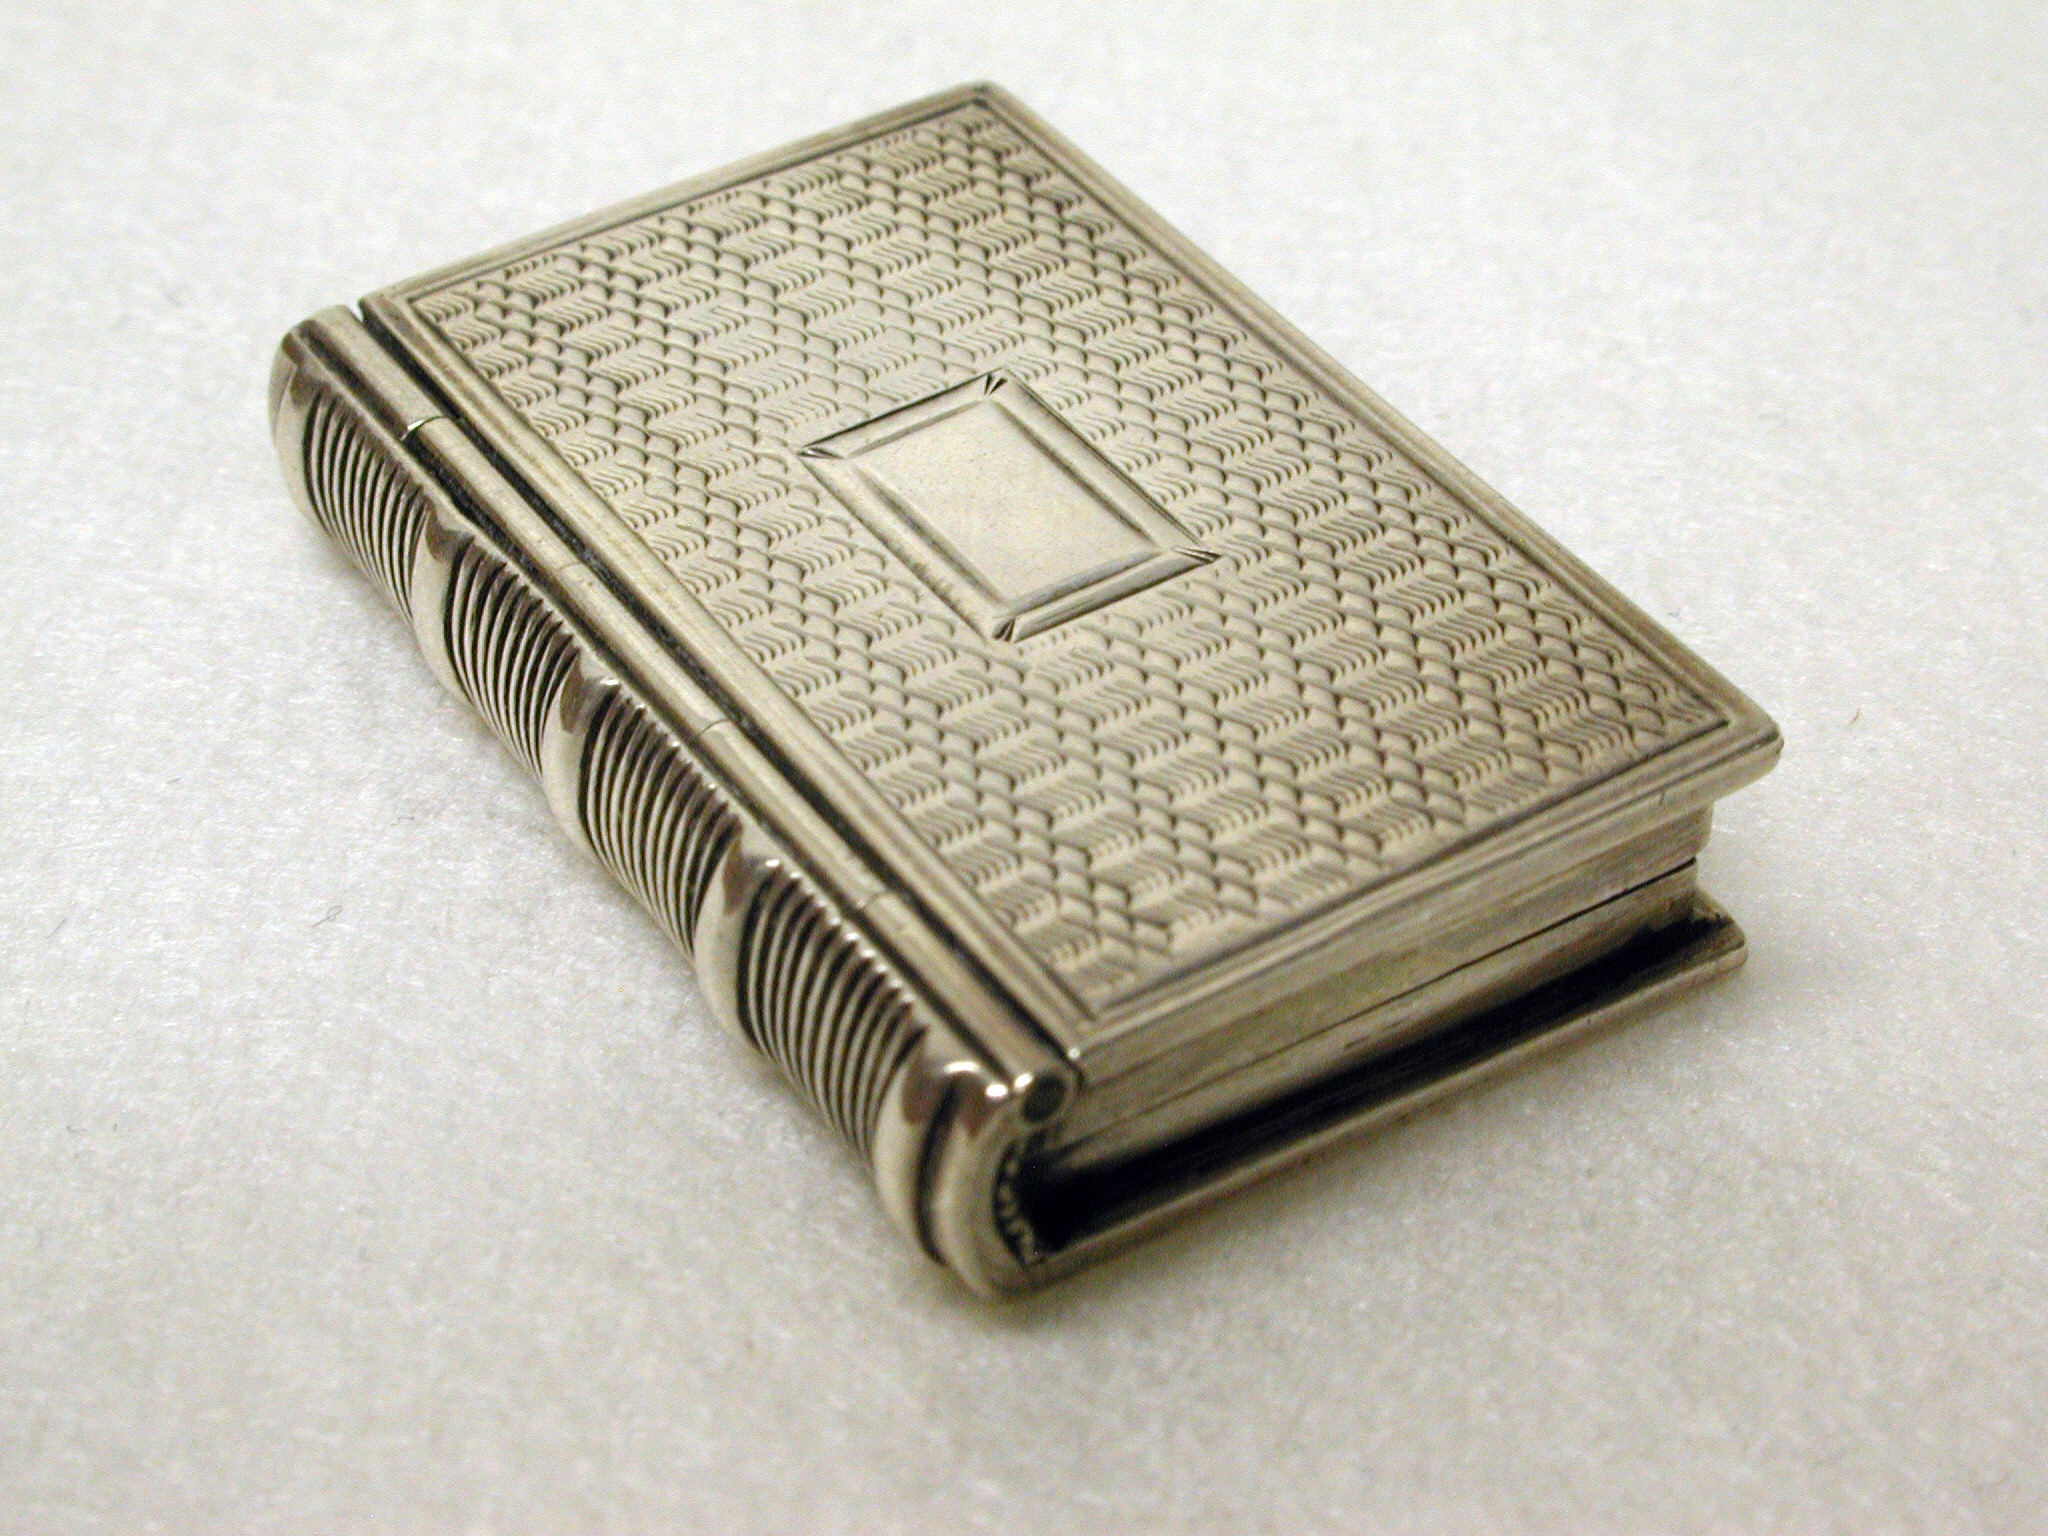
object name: vinaigrette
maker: taylor & perry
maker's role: maker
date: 1834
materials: silver